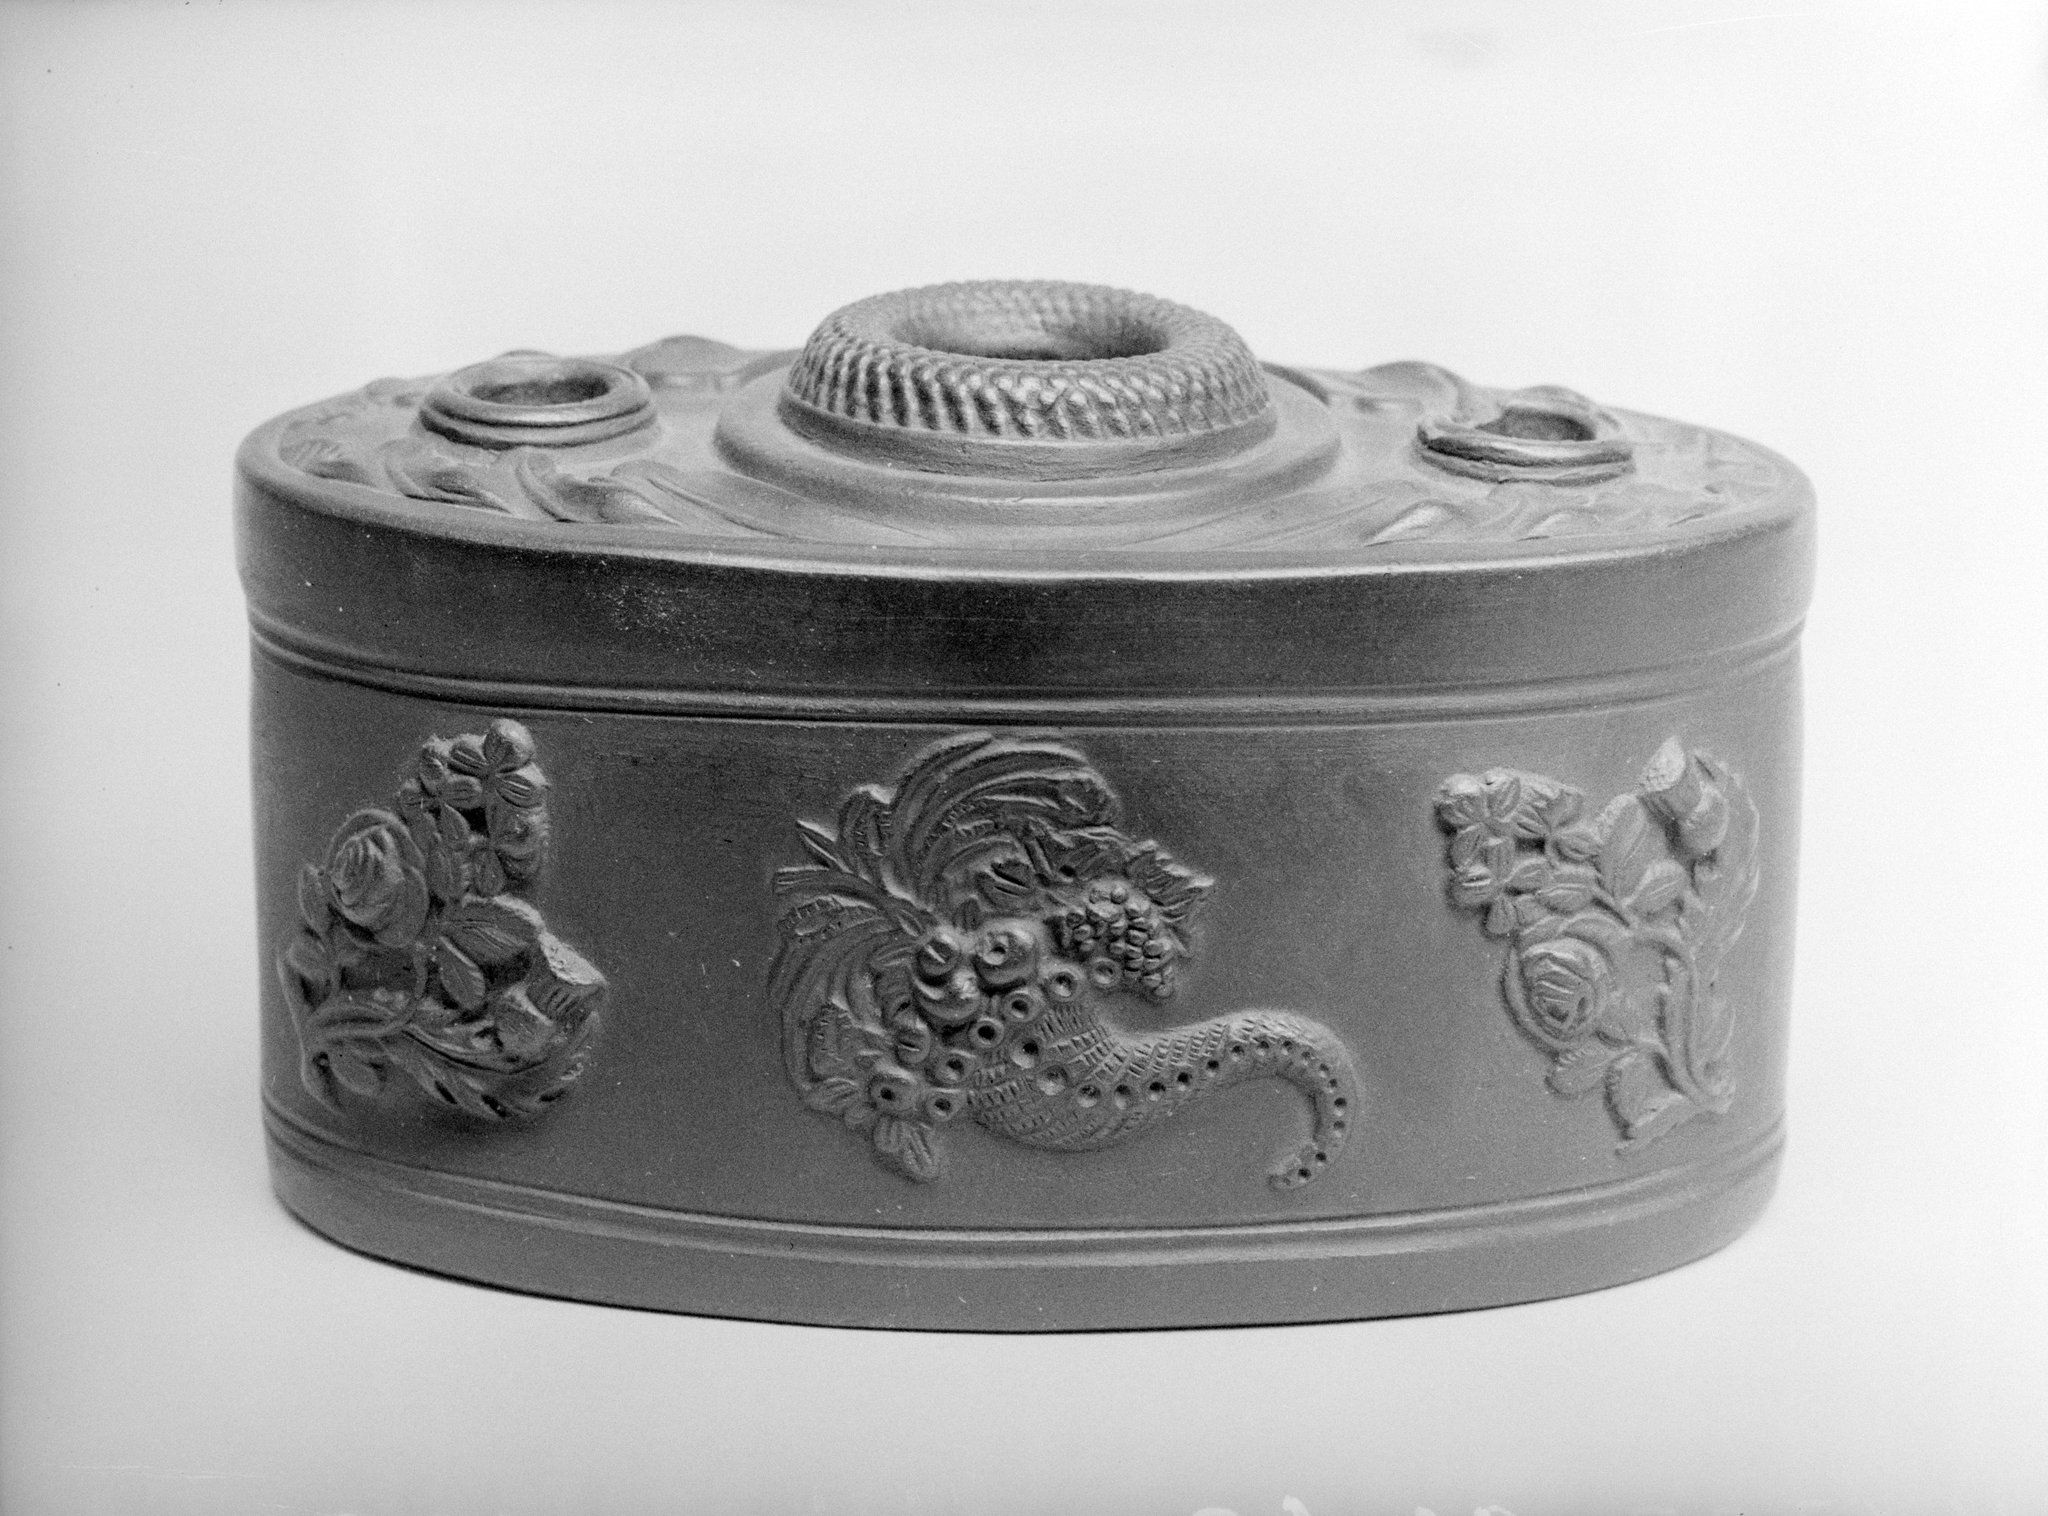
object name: inkwell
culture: british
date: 1770-1800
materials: stone, earthenware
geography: england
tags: cornucopia,flowers